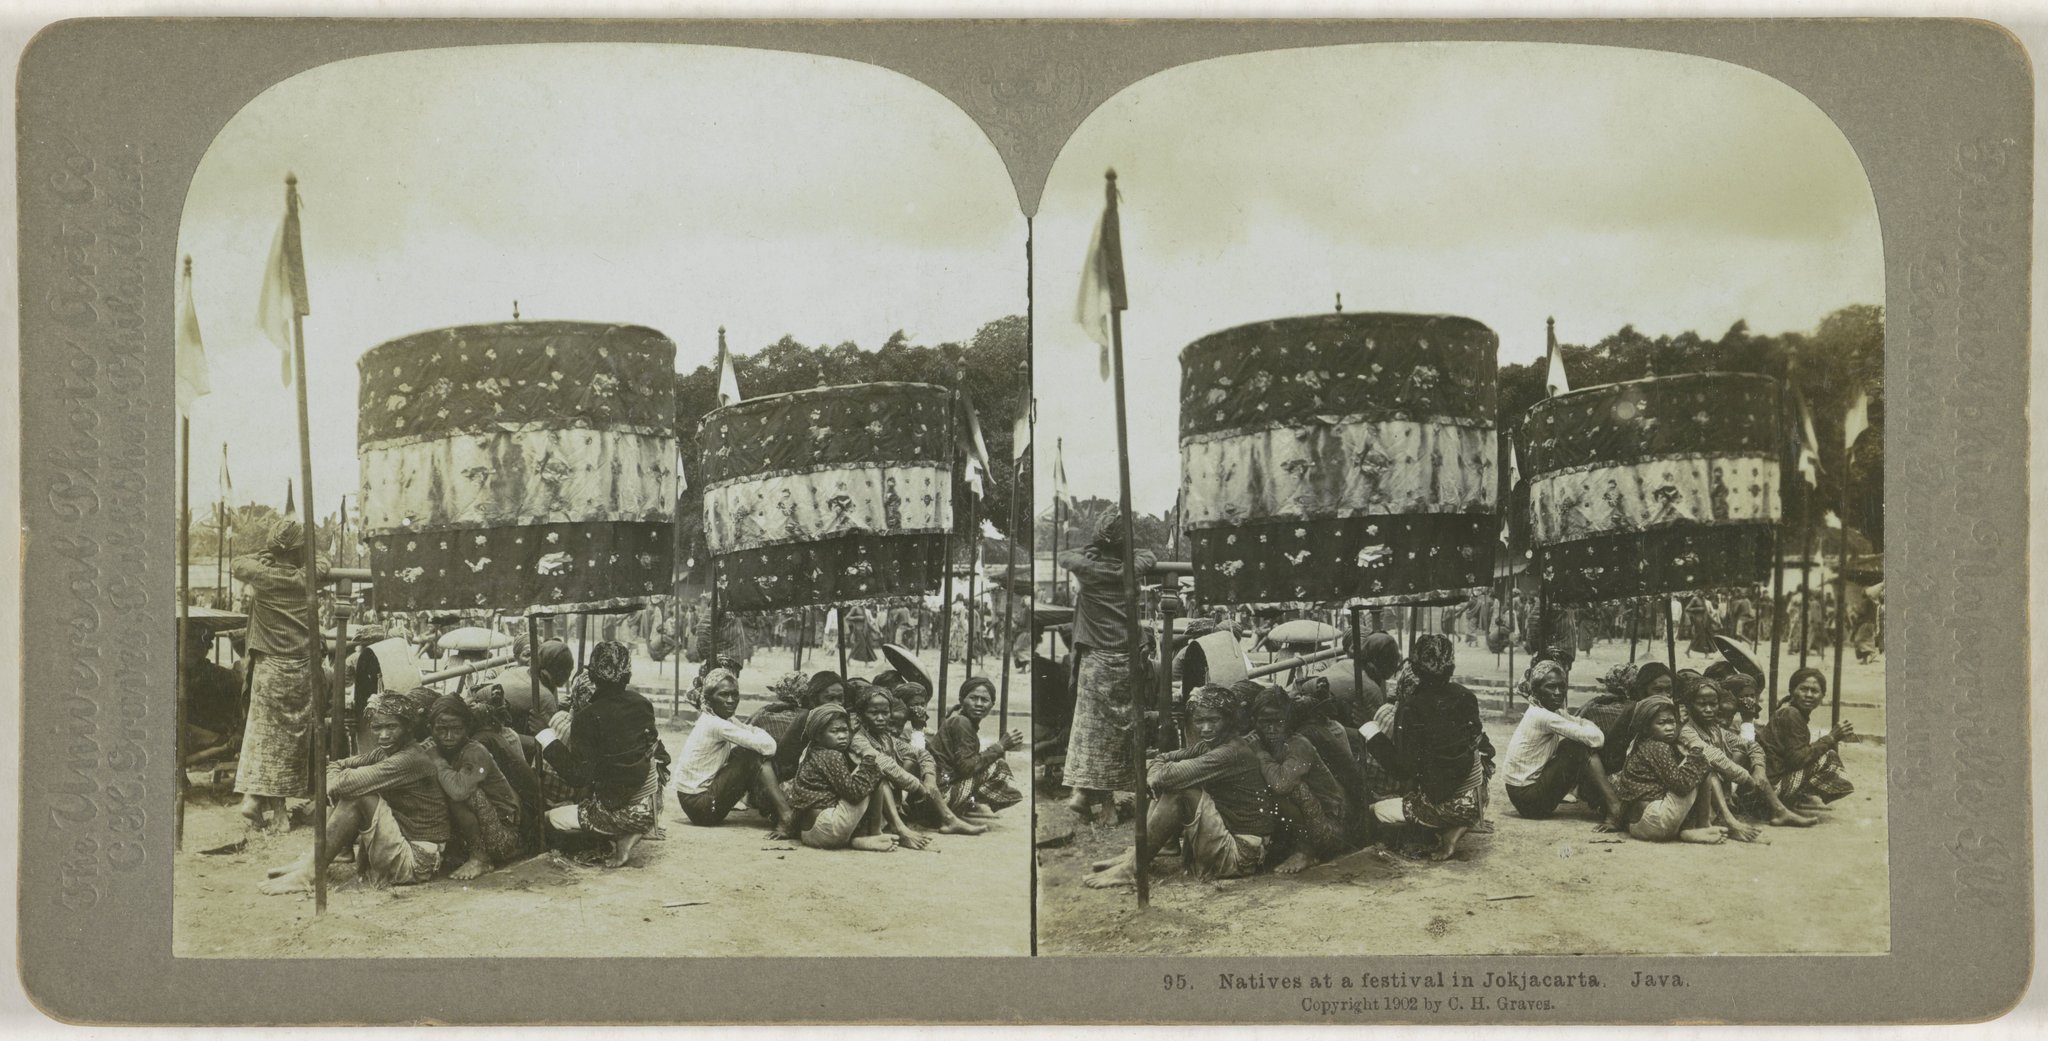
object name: stereograph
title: Natives at a festival in Jokjacarta. Java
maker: carleton harlow graves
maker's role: fotograaf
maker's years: 1867-1943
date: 1902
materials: paper, cardboard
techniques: gelatin silver print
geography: philadelphia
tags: public festivities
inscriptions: number: ‘95.’, copyright notice: ‘Copyright 1902 by C. H. Graves.’, number: ‘35’